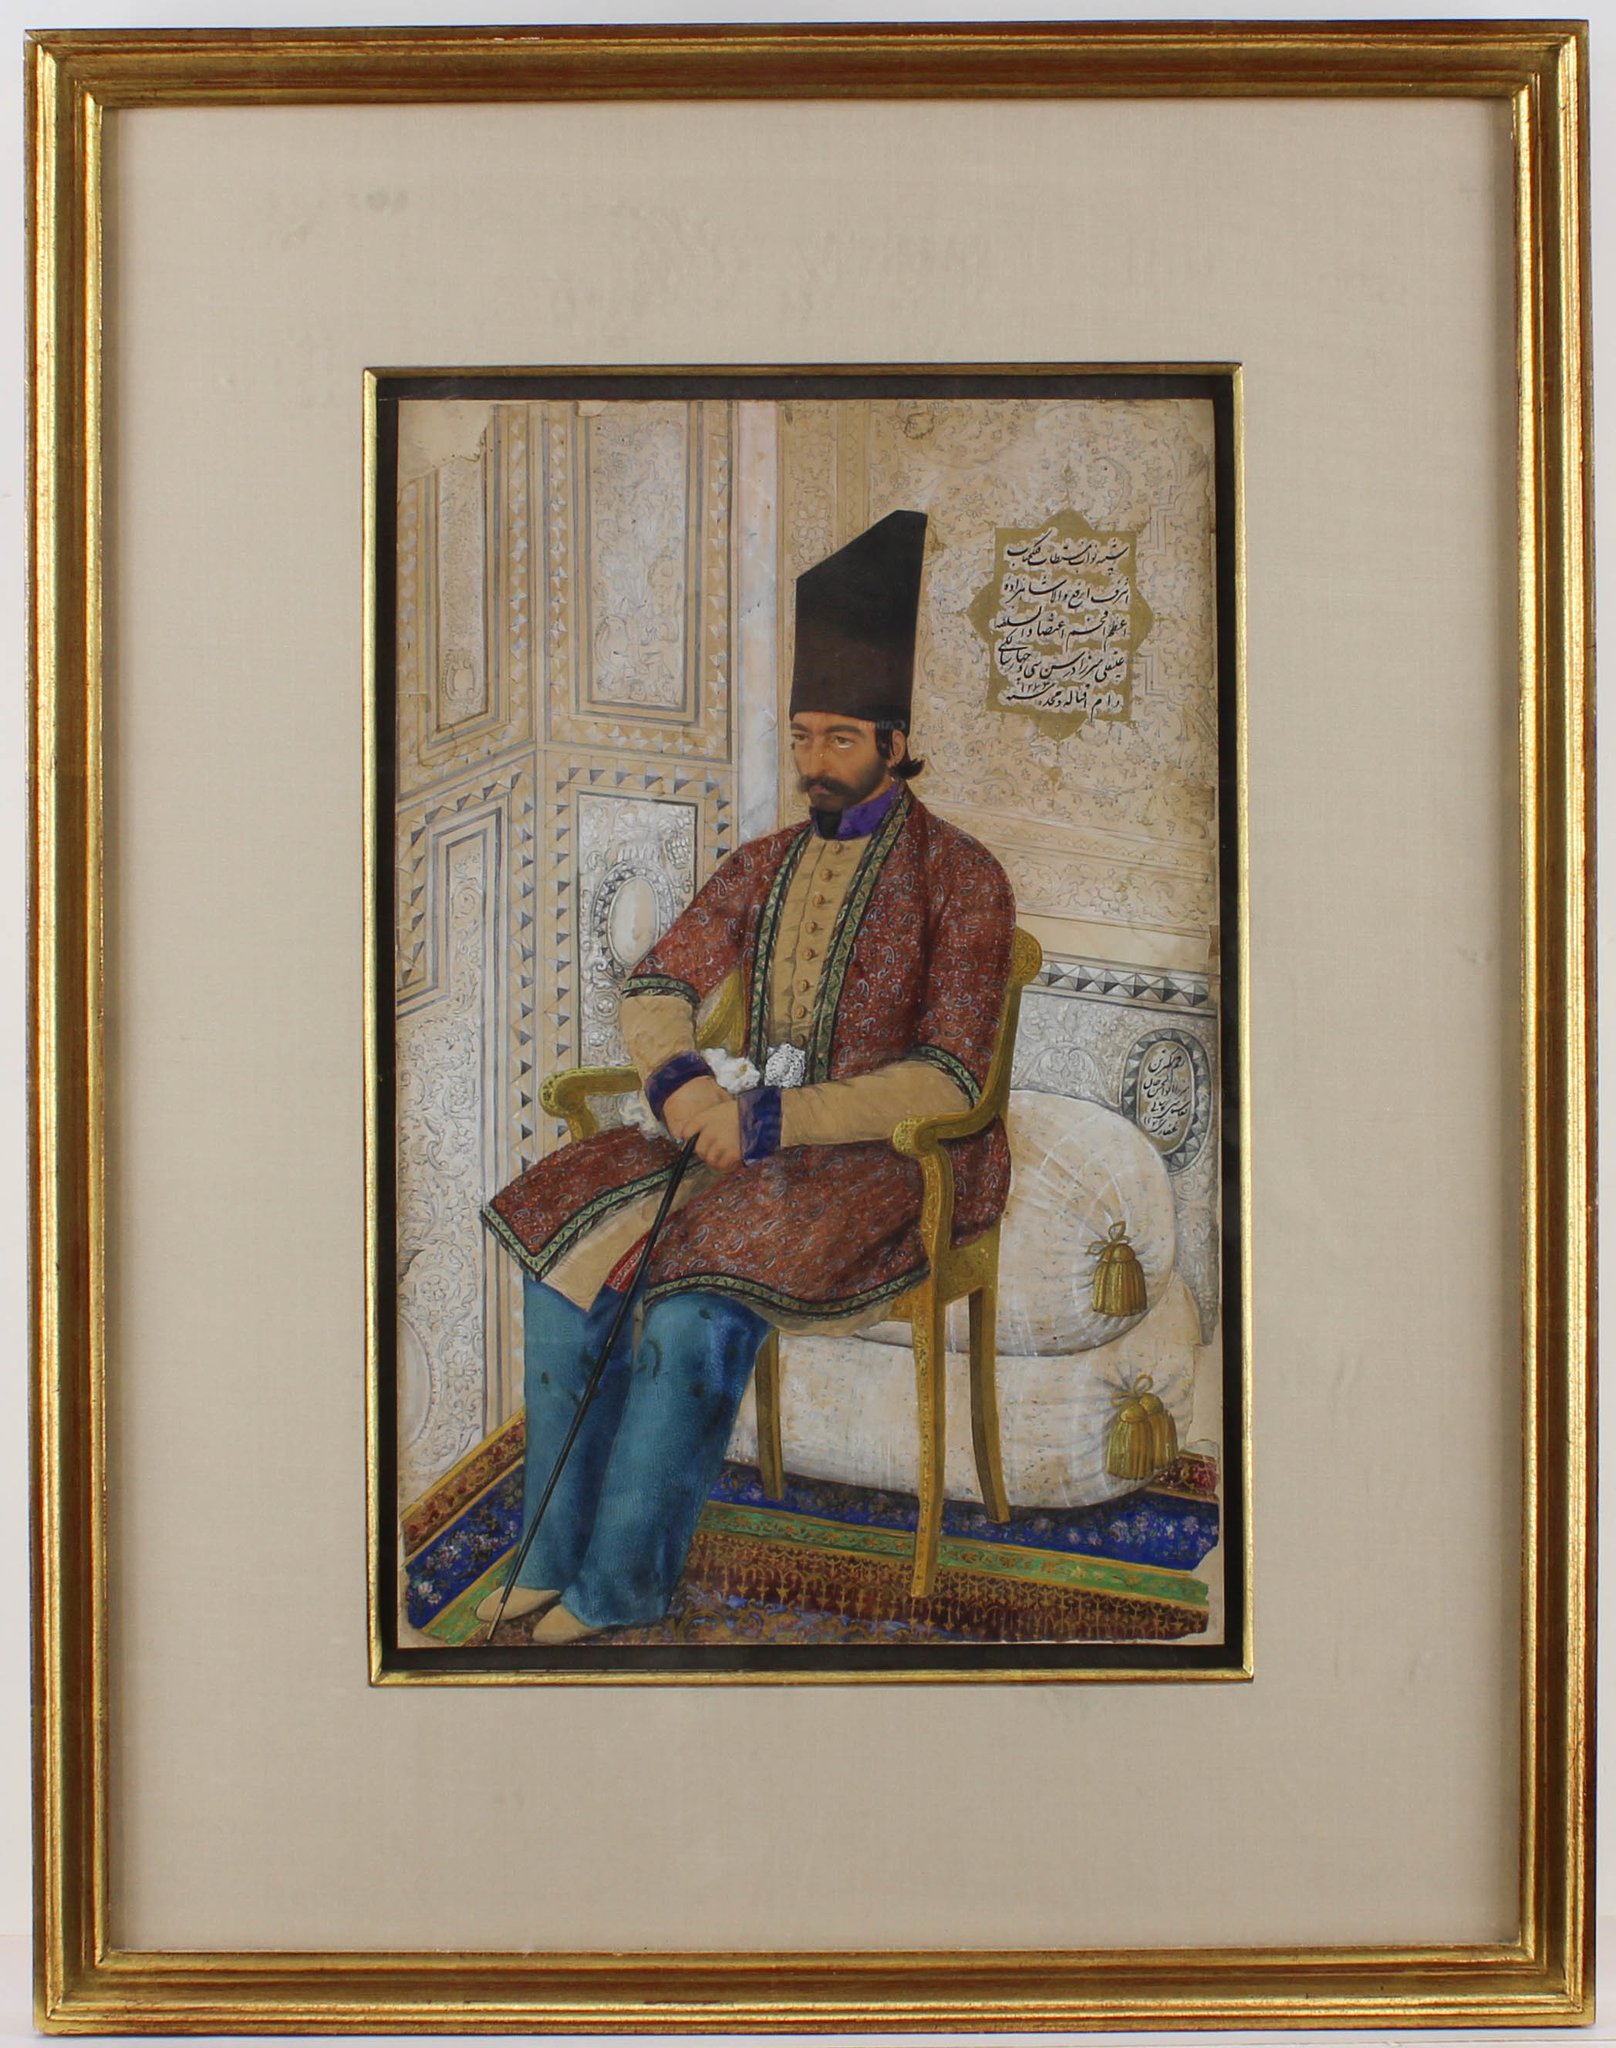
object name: illustrated single work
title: Portrait of `Ali Quli Mirza, I`tizad al-Saltana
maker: abu`l hasan ghaffari, known as sani' al-mulk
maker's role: artist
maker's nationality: iranian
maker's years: 1814-1866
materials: gold, ink, paper, watercolor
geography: iran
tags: men,portraits